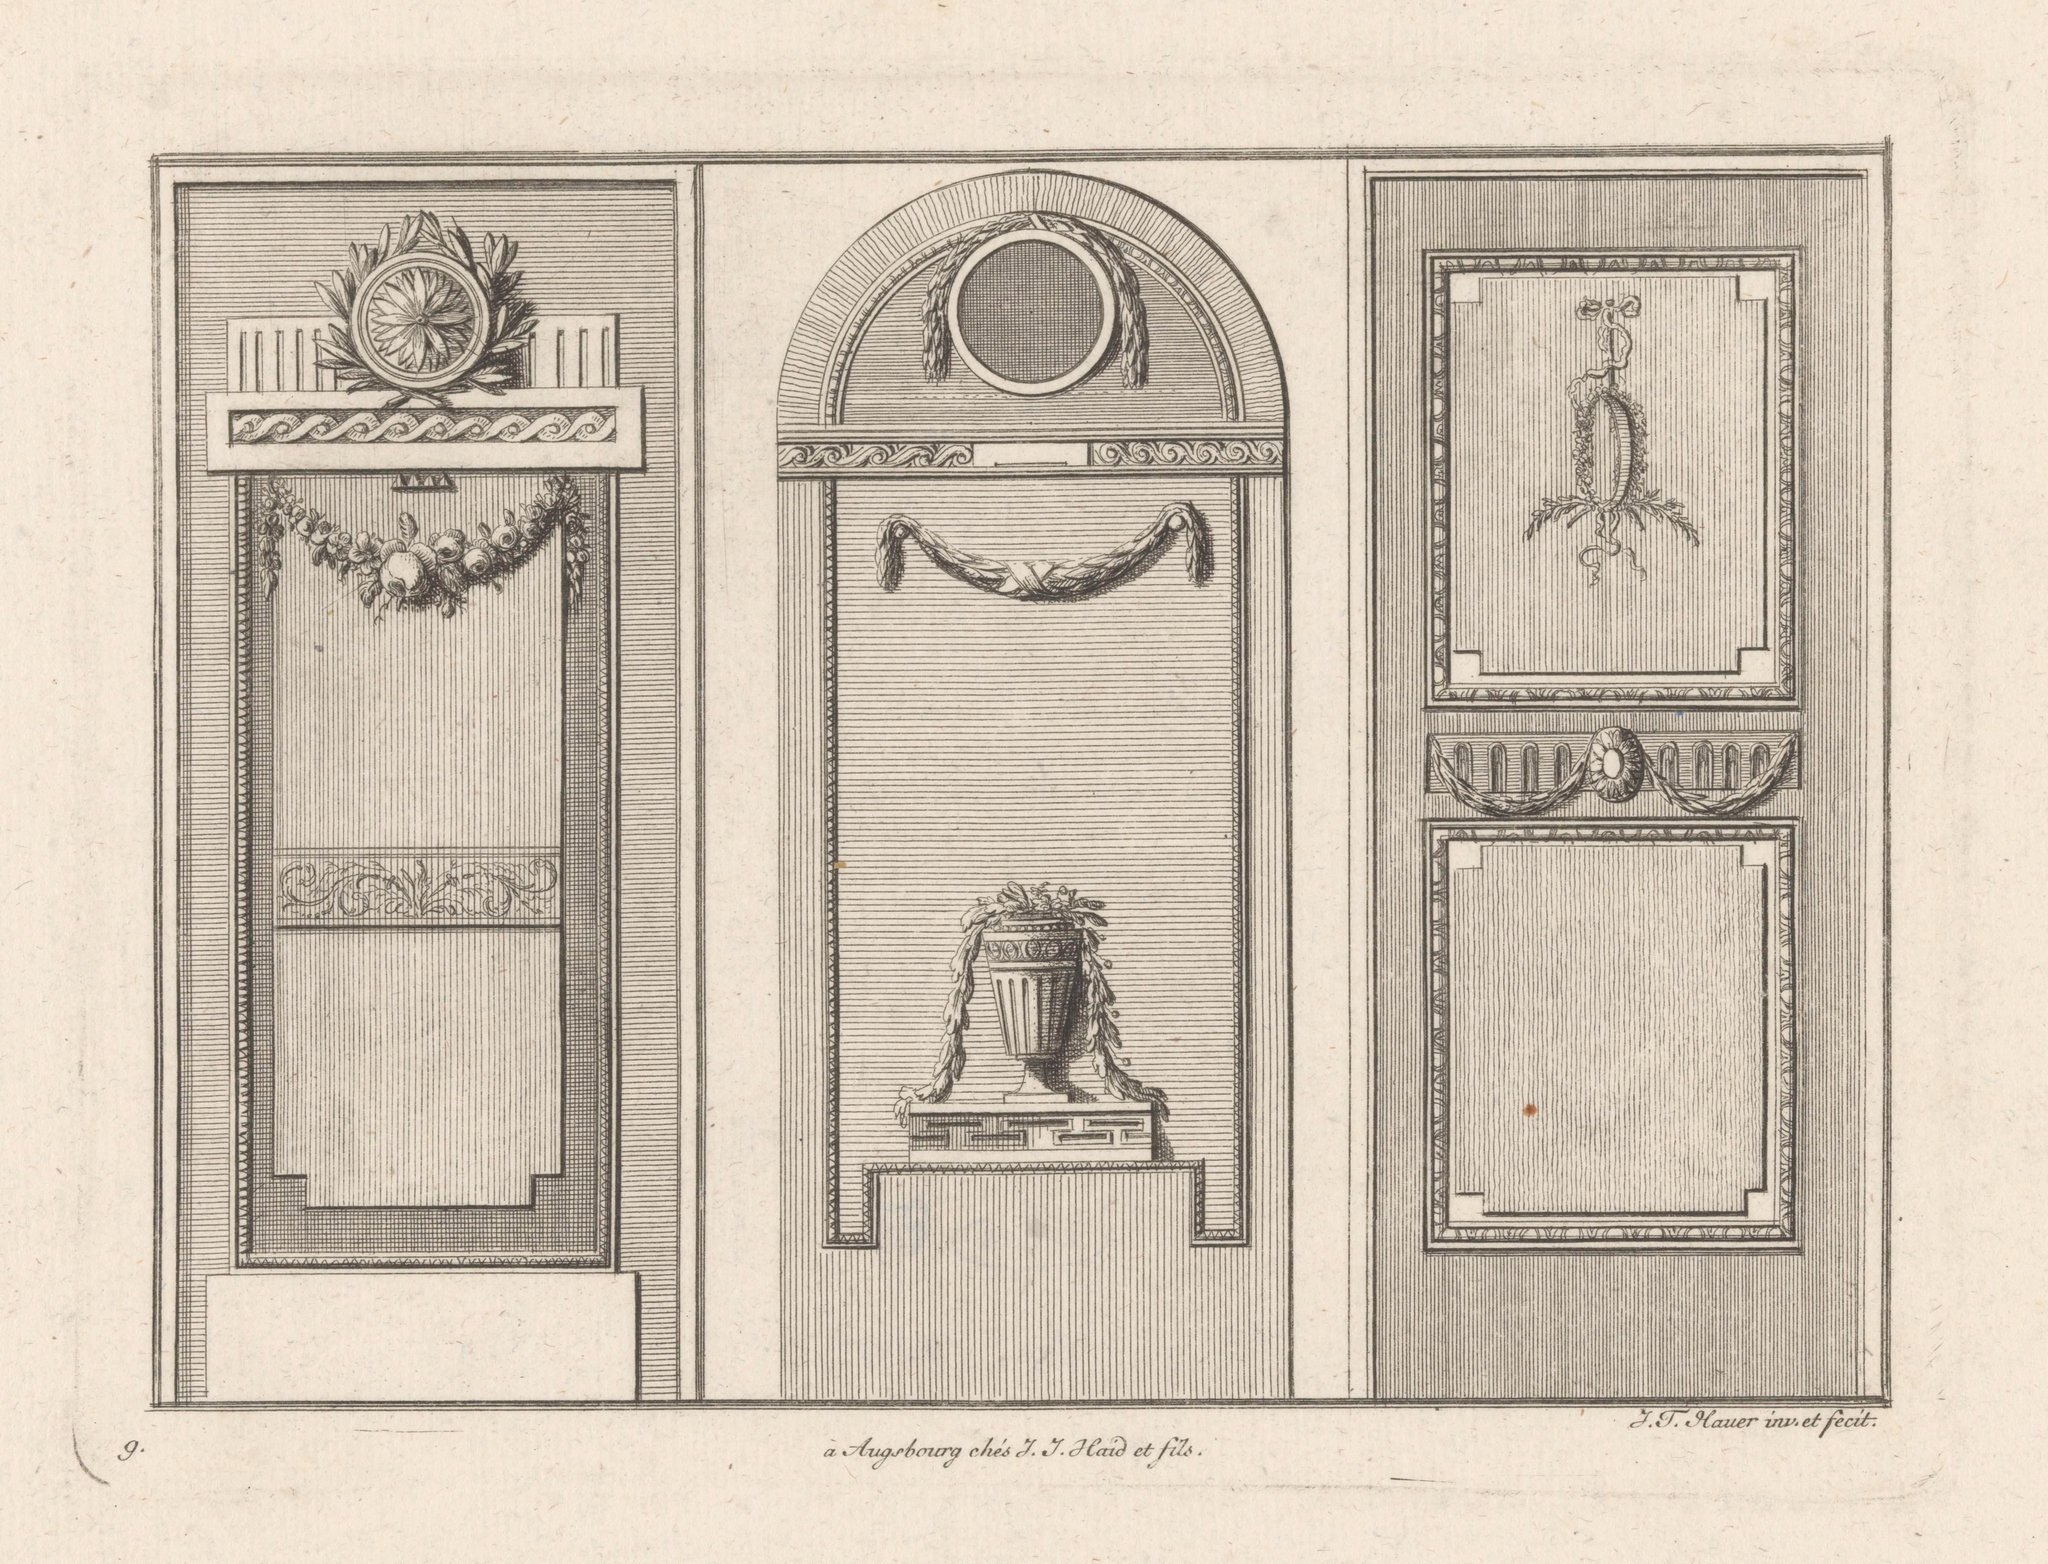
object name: print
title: Drie panelen met guirlandes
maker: johann thomas hauer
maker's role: print maker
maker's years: 1748-1820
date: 1758-1767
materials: paper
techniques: engraving, etching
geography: augsburg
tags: panelling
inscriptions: collector's mark: Lugt 2760, collector's mark: Lugt 2228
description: Ontwerpen voor drie panelen met guirlandes en een vaas.